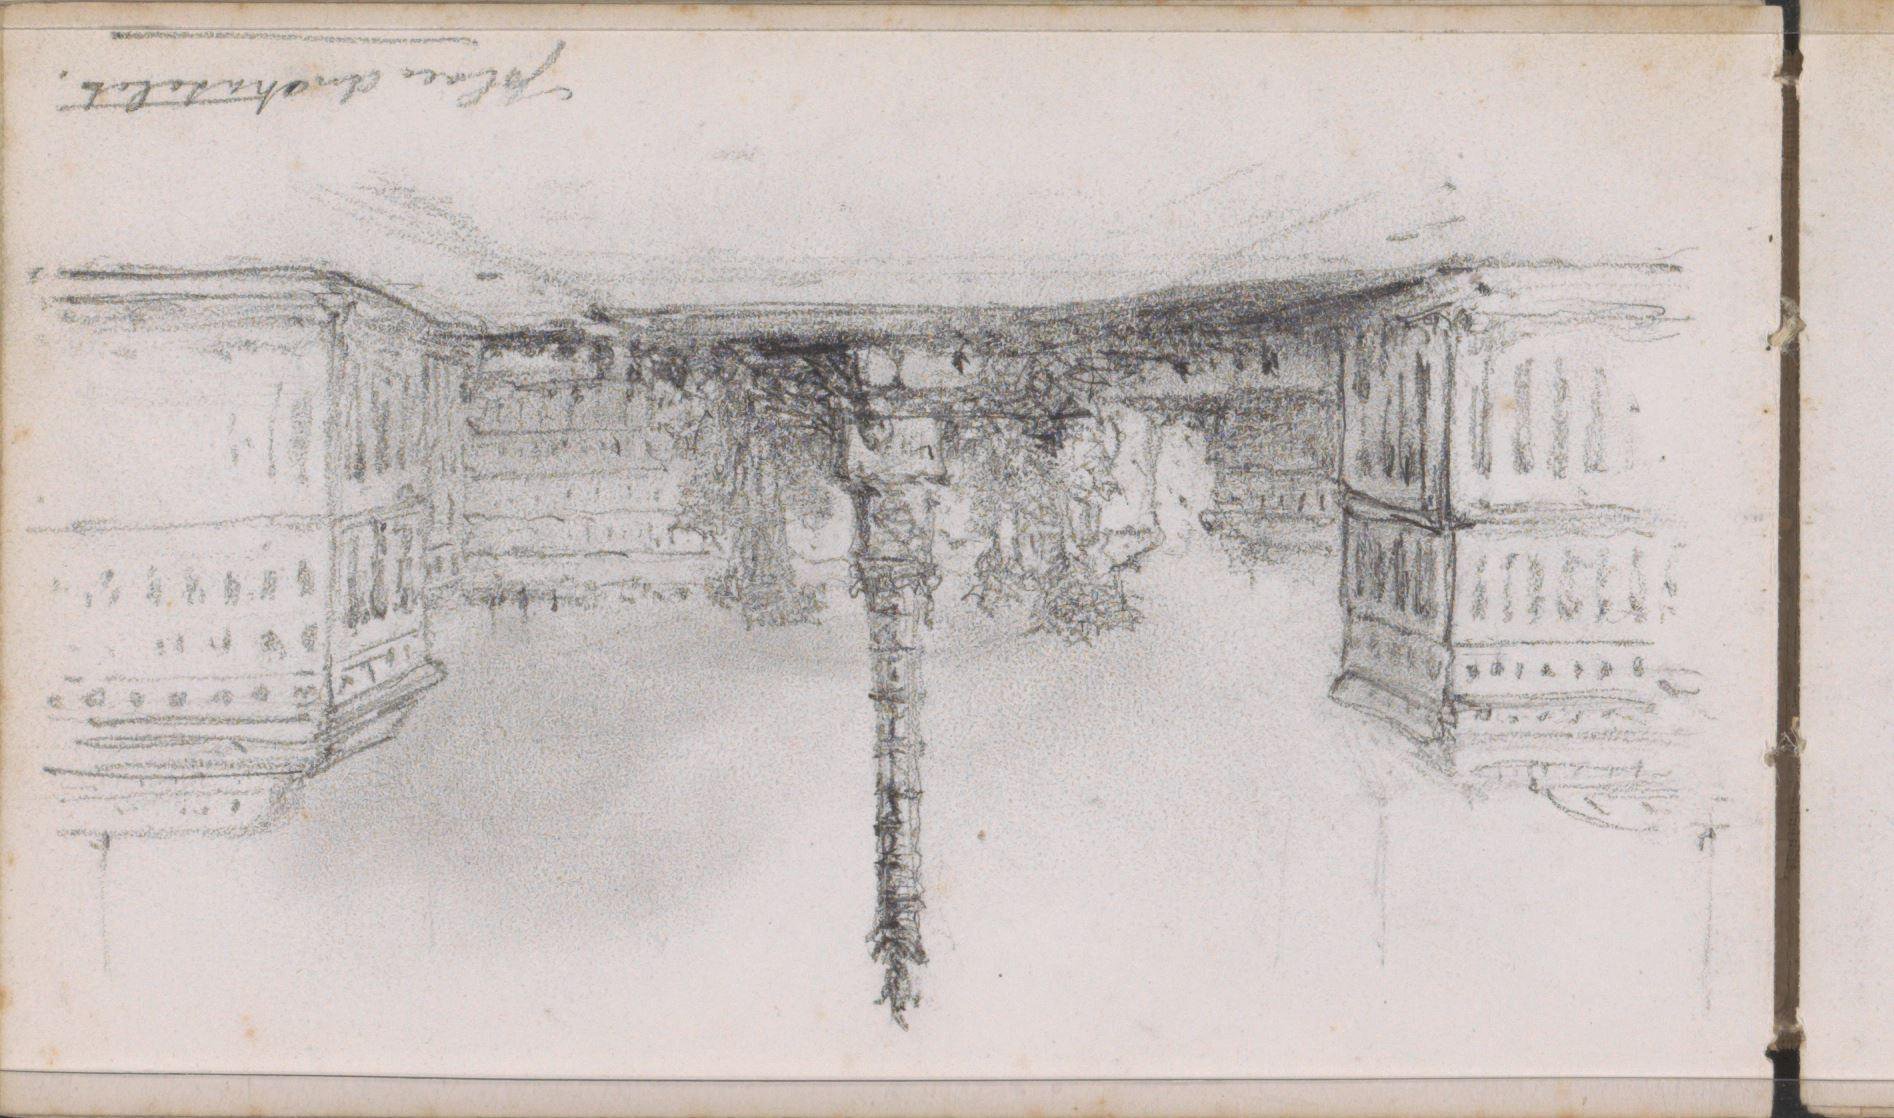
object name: sketchbook leaf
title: Place du Châtelet te Parijs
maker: maria vos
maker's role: draughtsman, painter, print maker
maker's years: 1824-1906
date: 1811-1867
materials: paper, pencil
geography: paris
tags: square, place, circus, etc., monument, statue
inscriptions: annotation: ‘place du chatelet.’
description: Blad 18 verso uit een schetsboek met 40 bladen.